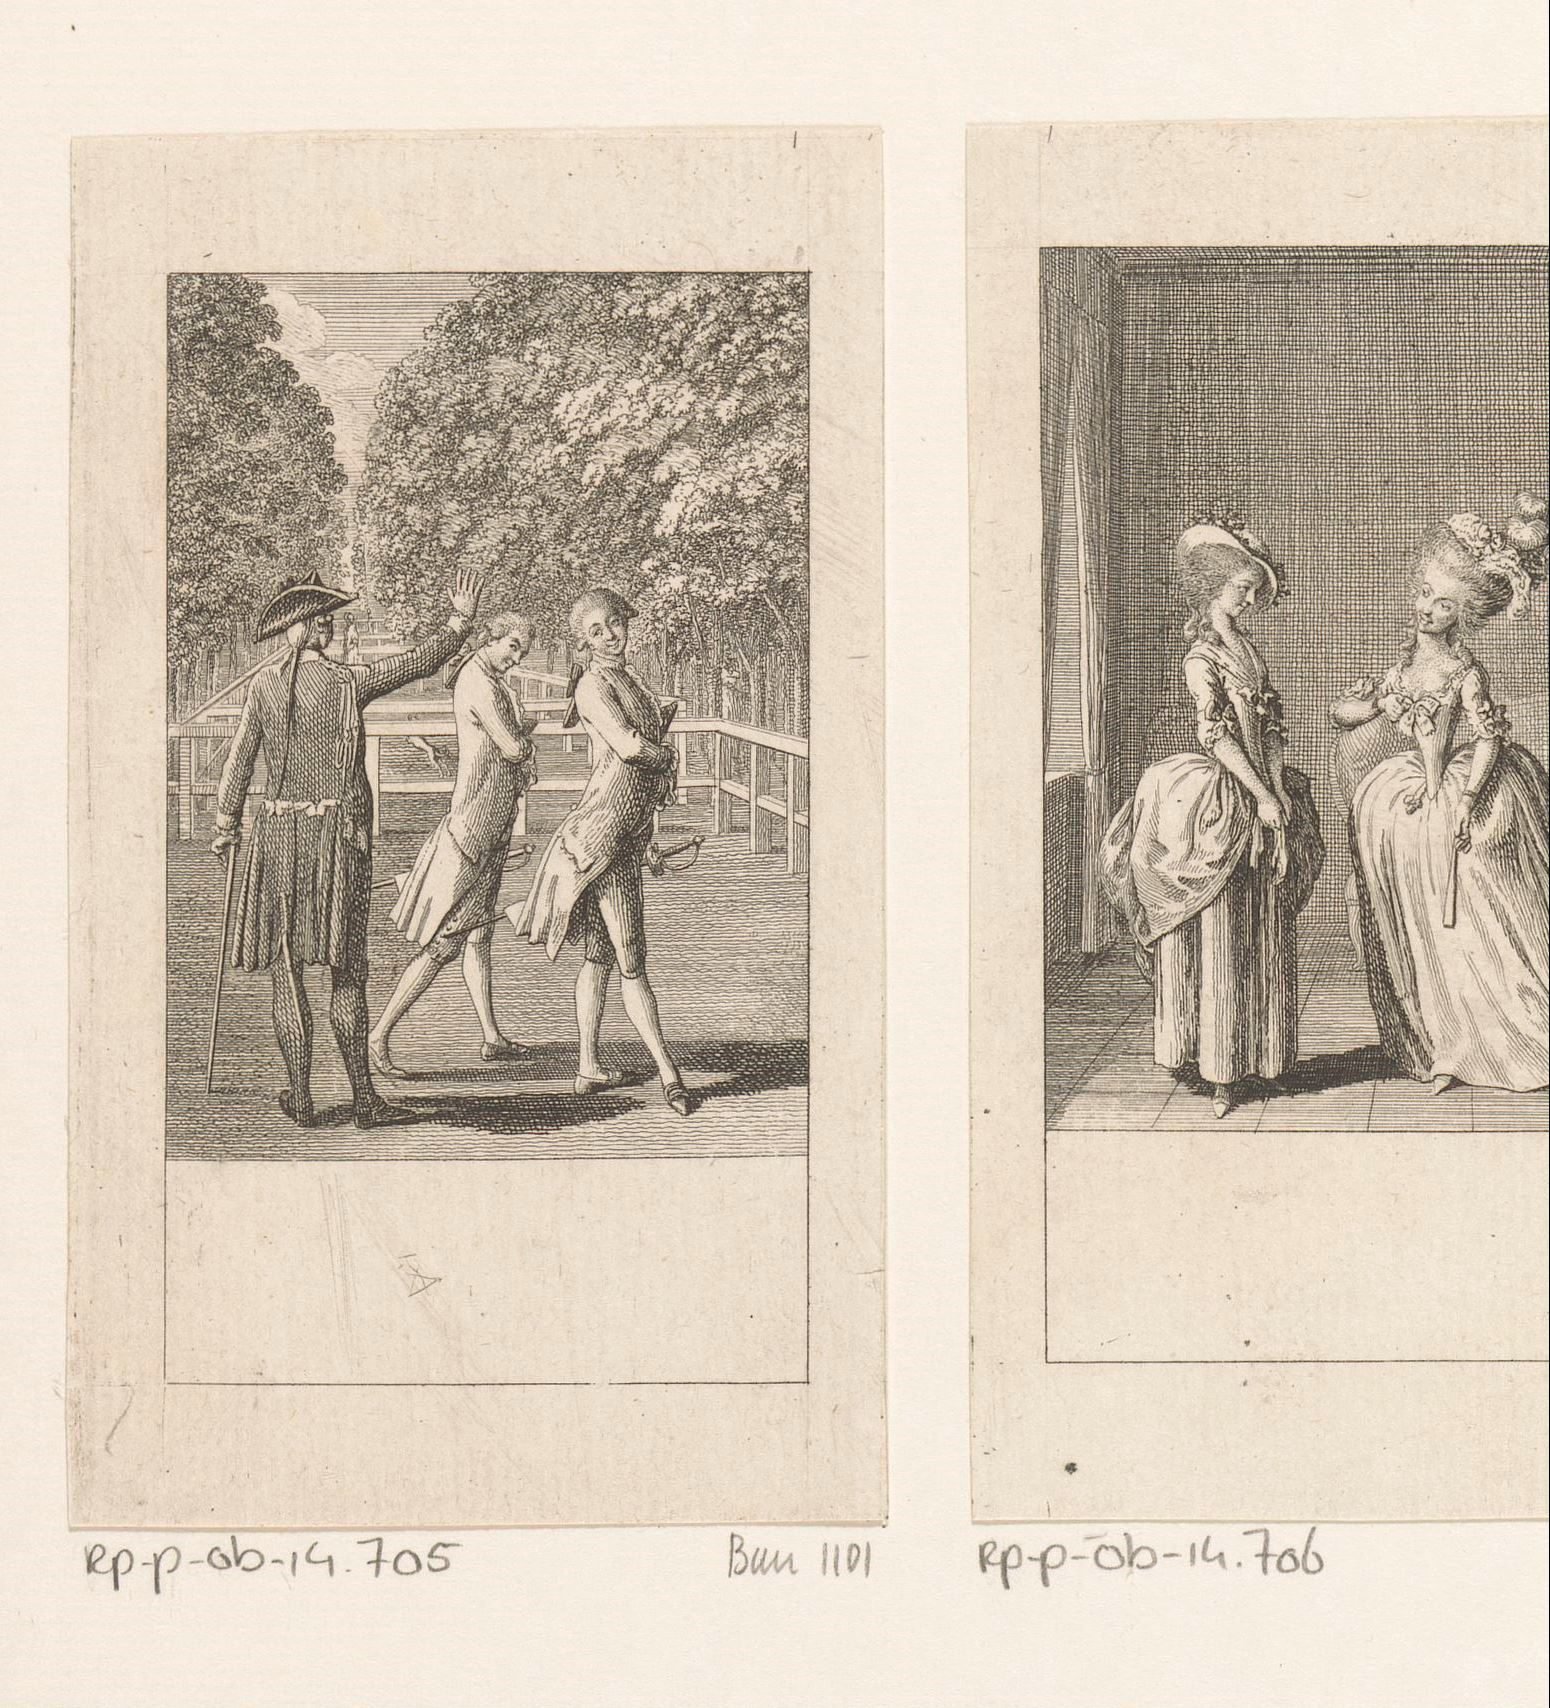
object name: print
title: Drie heren in de dierentuin opzoek naar een bruid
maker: daniel nikolaus chodowiecki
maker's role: draughtsman, print maker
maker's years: 1726-1801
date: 1784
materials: paper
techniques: etching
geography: berlin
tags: literature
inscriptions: collector's mark: Lugt 2228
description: Vervaardigd voor Christian Friedrich Bretzners 'Eheprocurator'. Latere staat gebruikt voor: Konigl. Grosbrit. Genealogischen Kalender auf das Jahr 1785. Lauenburg: J. G. Berenberg, 1784.